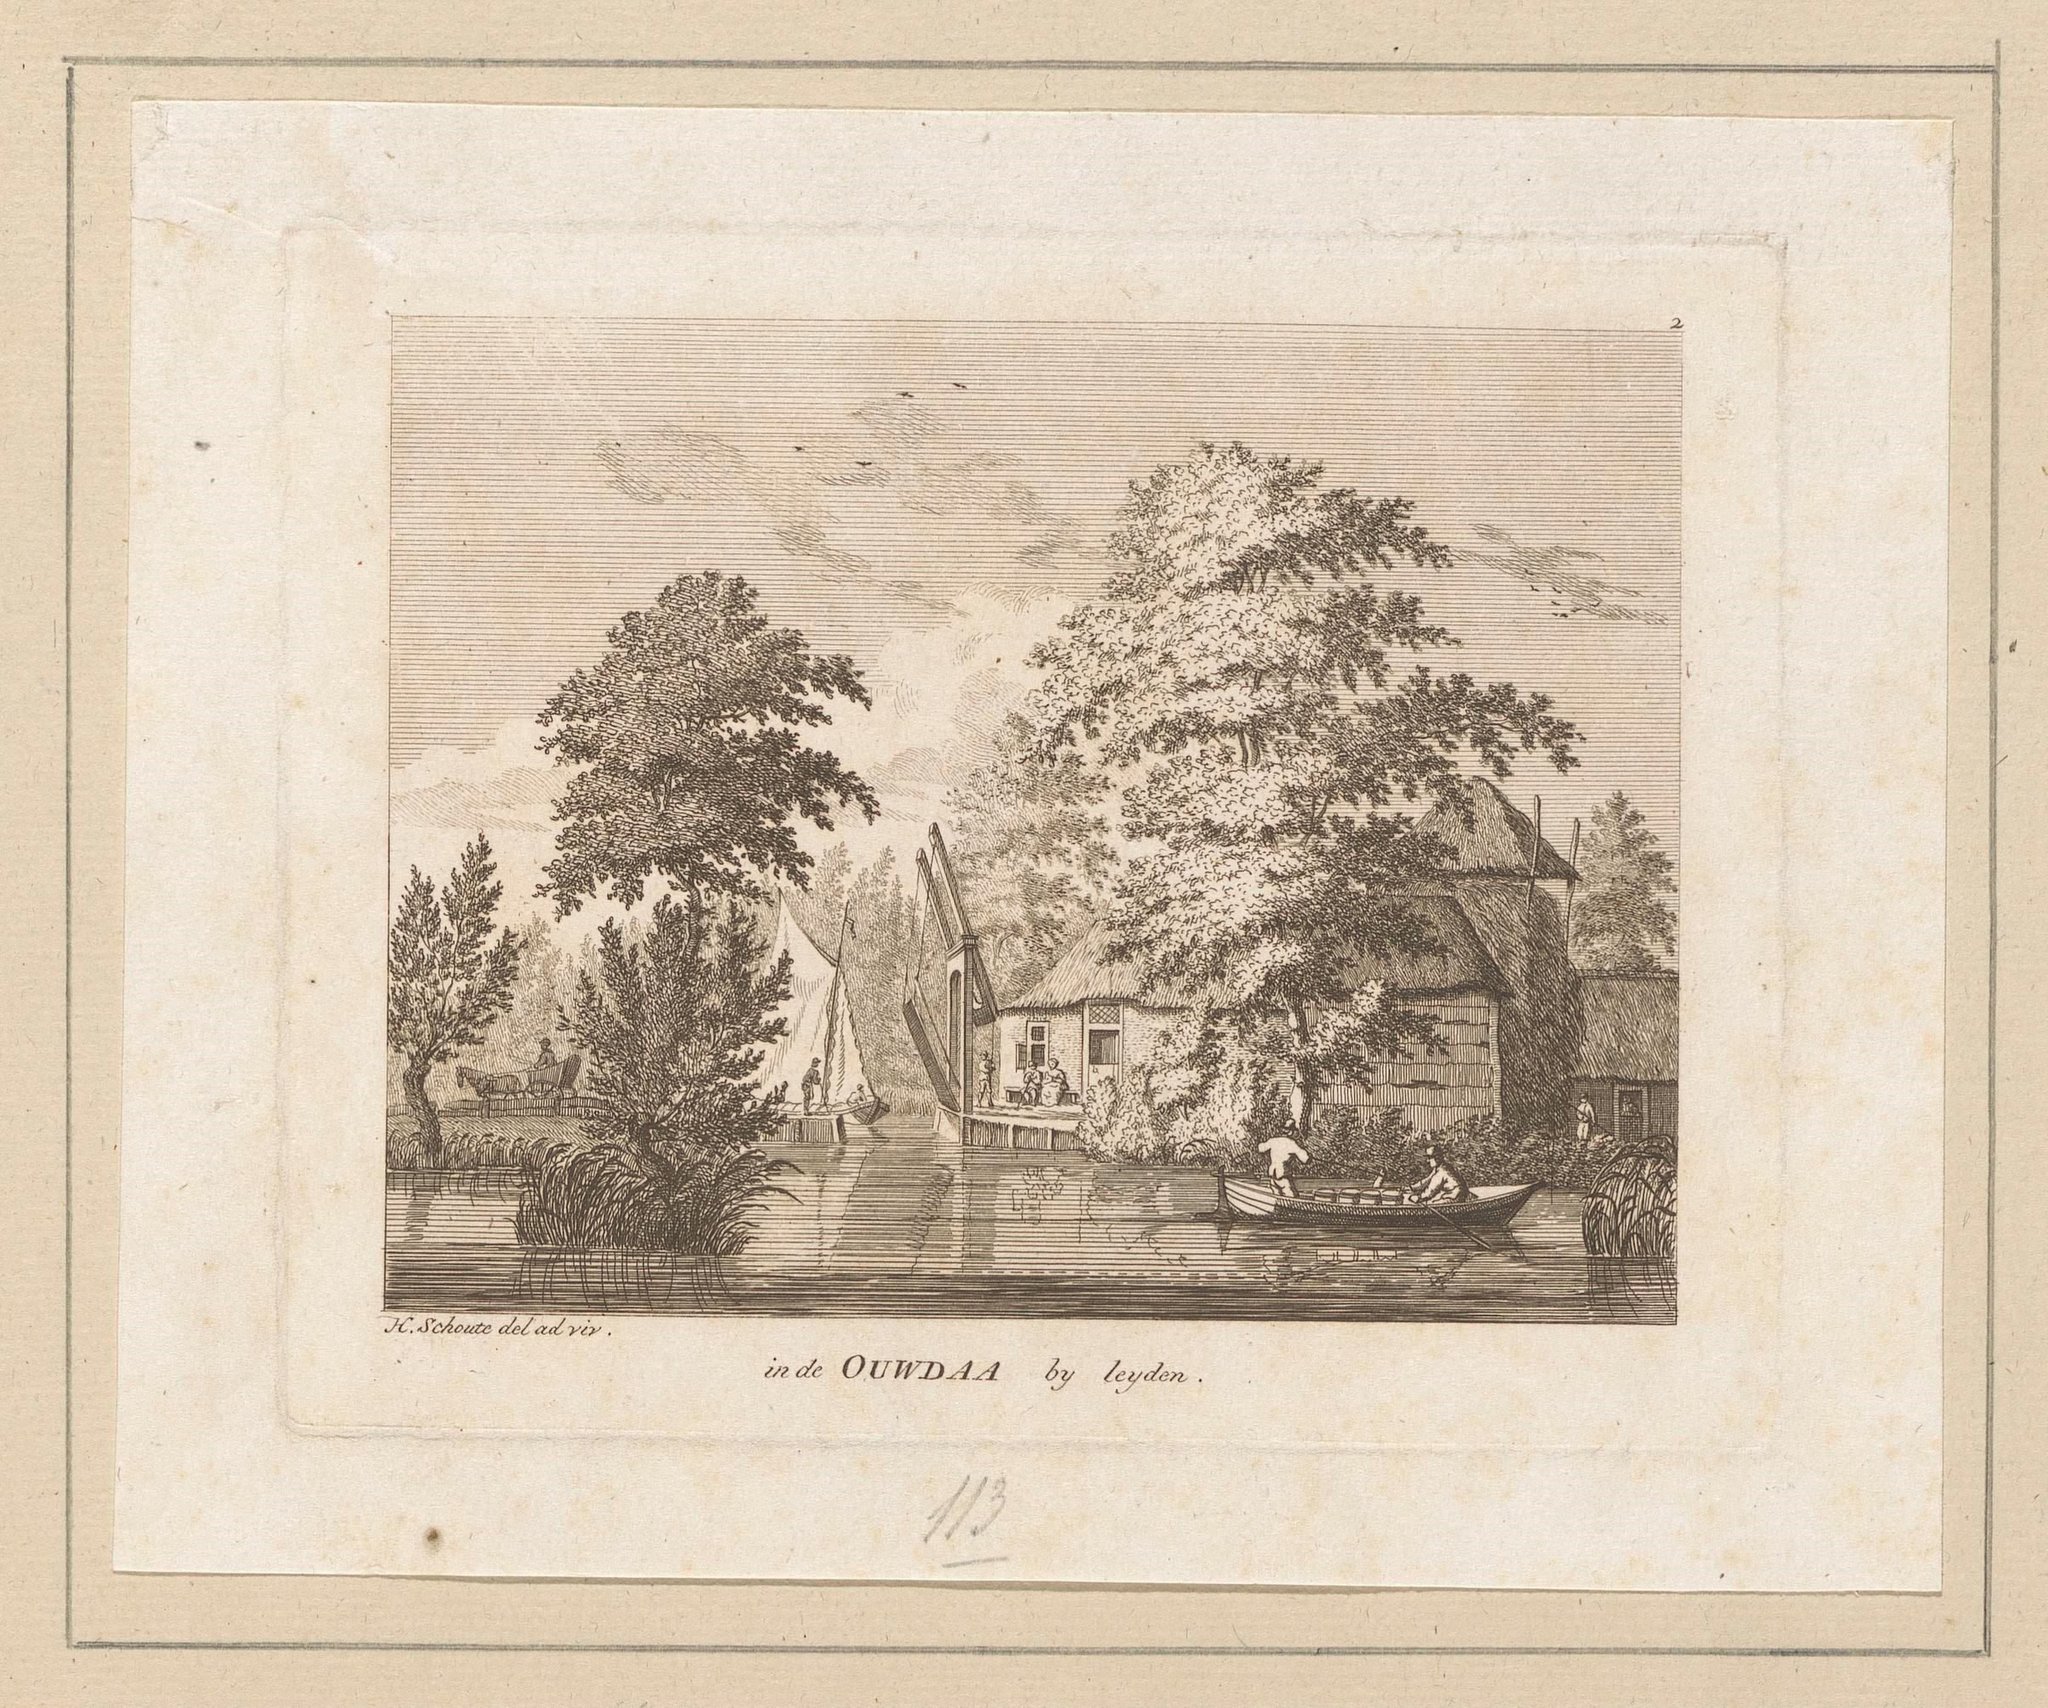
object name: print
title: Gezicht op de Oude Ade bij Leiden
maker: hermanus petrus schouten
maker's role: draughtsman, painter, print maker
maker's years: 1747-1822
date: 1762-1822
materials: paper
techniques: engraving, etching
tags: river, bridge, farm (building), leiden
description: Gezicht op een boerderij aan de Oude Ade bij Leiden. Links passeert een zeilboot een ophaalbruggetje. Rechts een roeiboot. Rechtsboven genummerd: 2.